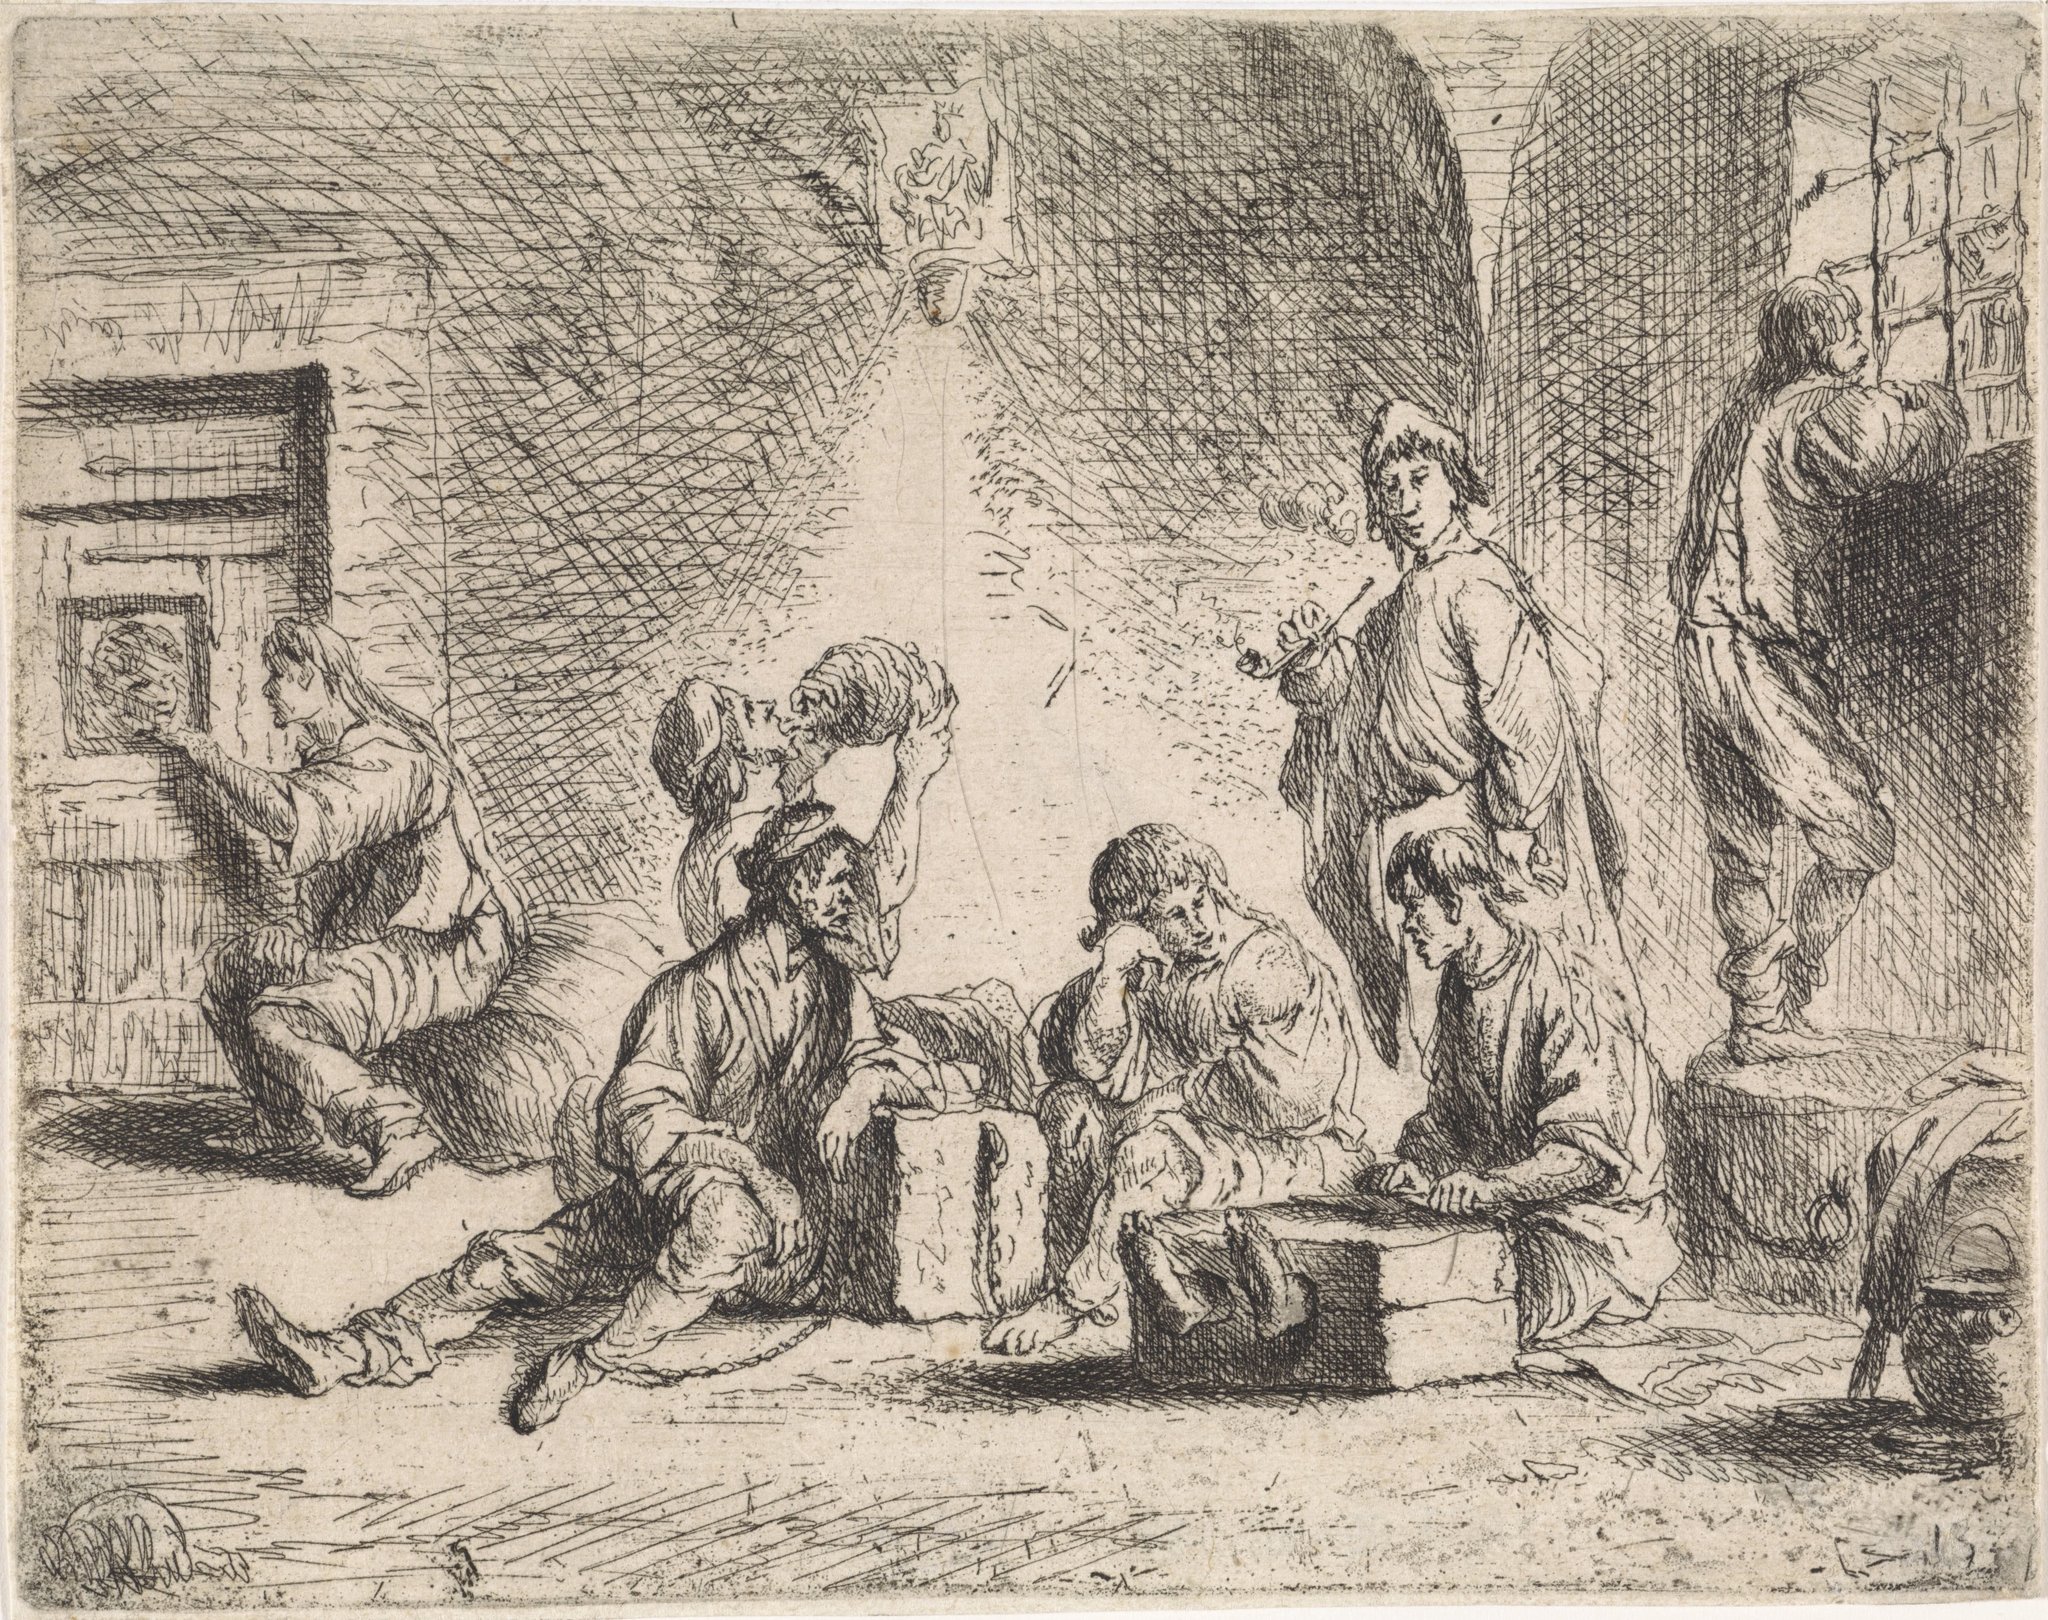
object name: print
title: Gevangenen in kerker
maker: cornelis de wael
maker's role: draughtsman, print maker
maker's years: 1592-1667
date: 1630-1648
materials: paper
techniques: etching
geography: italy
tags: prison, jail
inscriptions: collector's mark: Lugt 2228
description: De gevangenen zijn vastgeketend aan blokken. Eén van hen praat met iemand door het luik in de deur. Een ander kijkt door de tralies in het raam naar buiten.